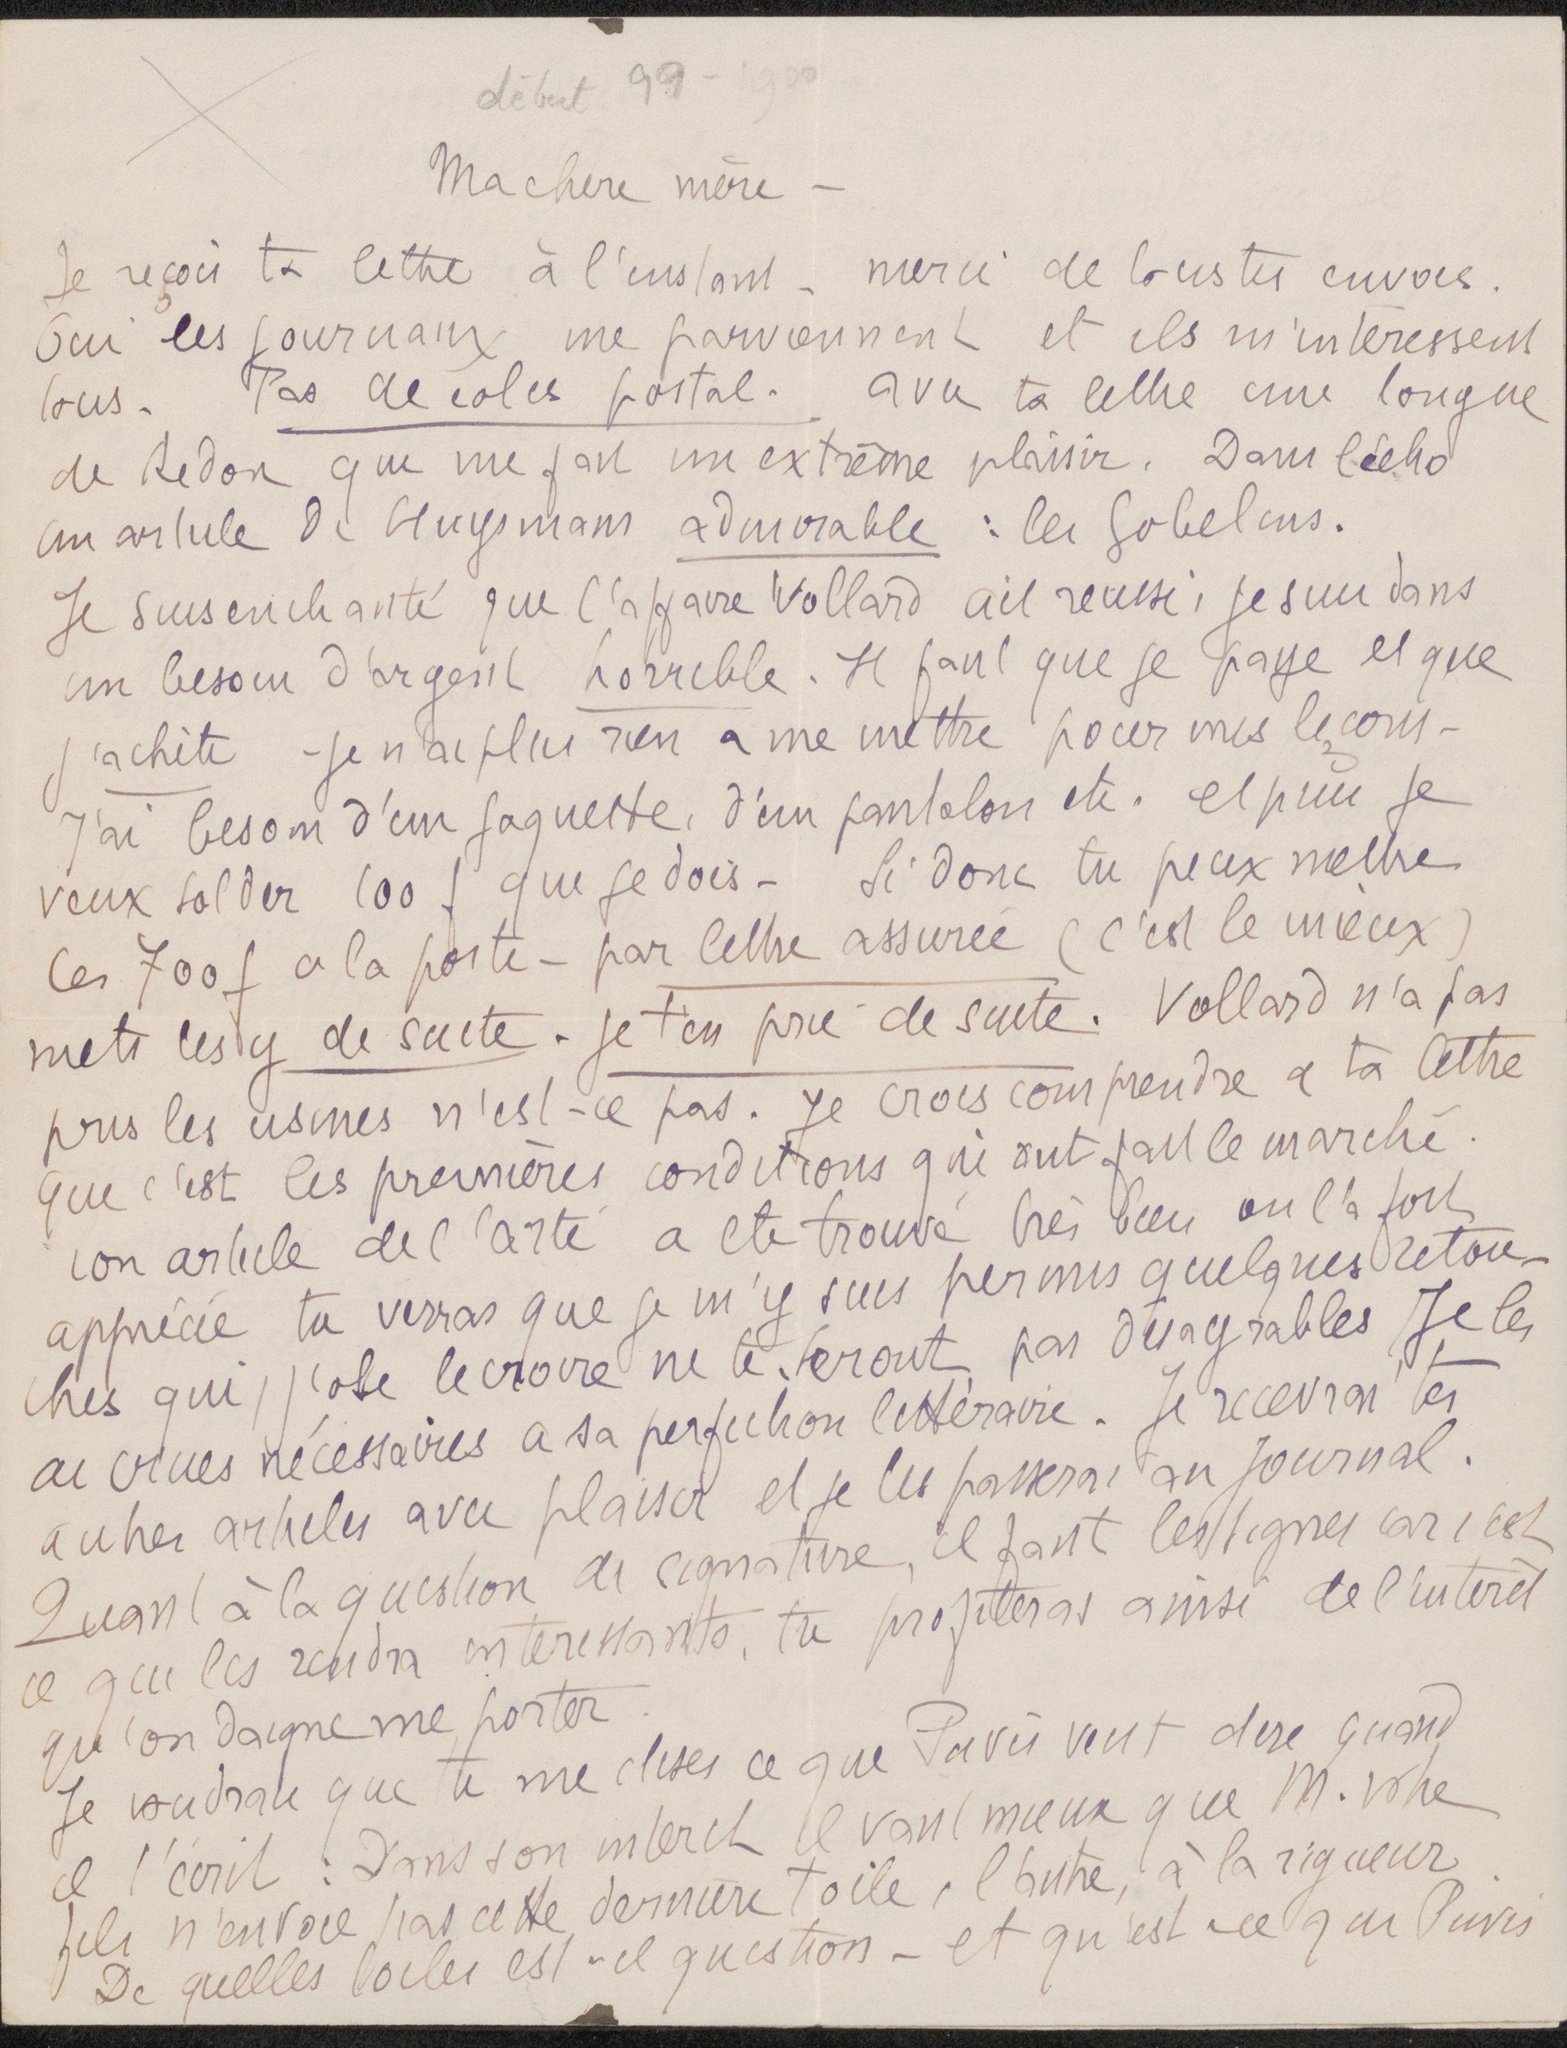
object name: letter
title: Brief aan Héloïse Bernard-Bodin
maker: émile bernard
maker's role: print maker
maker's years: 1868-1941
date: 1899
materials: ink, paper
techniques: pen, writing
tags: héloïse bernard-bodin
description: Brief gedateerd début 1899 in latere hand.